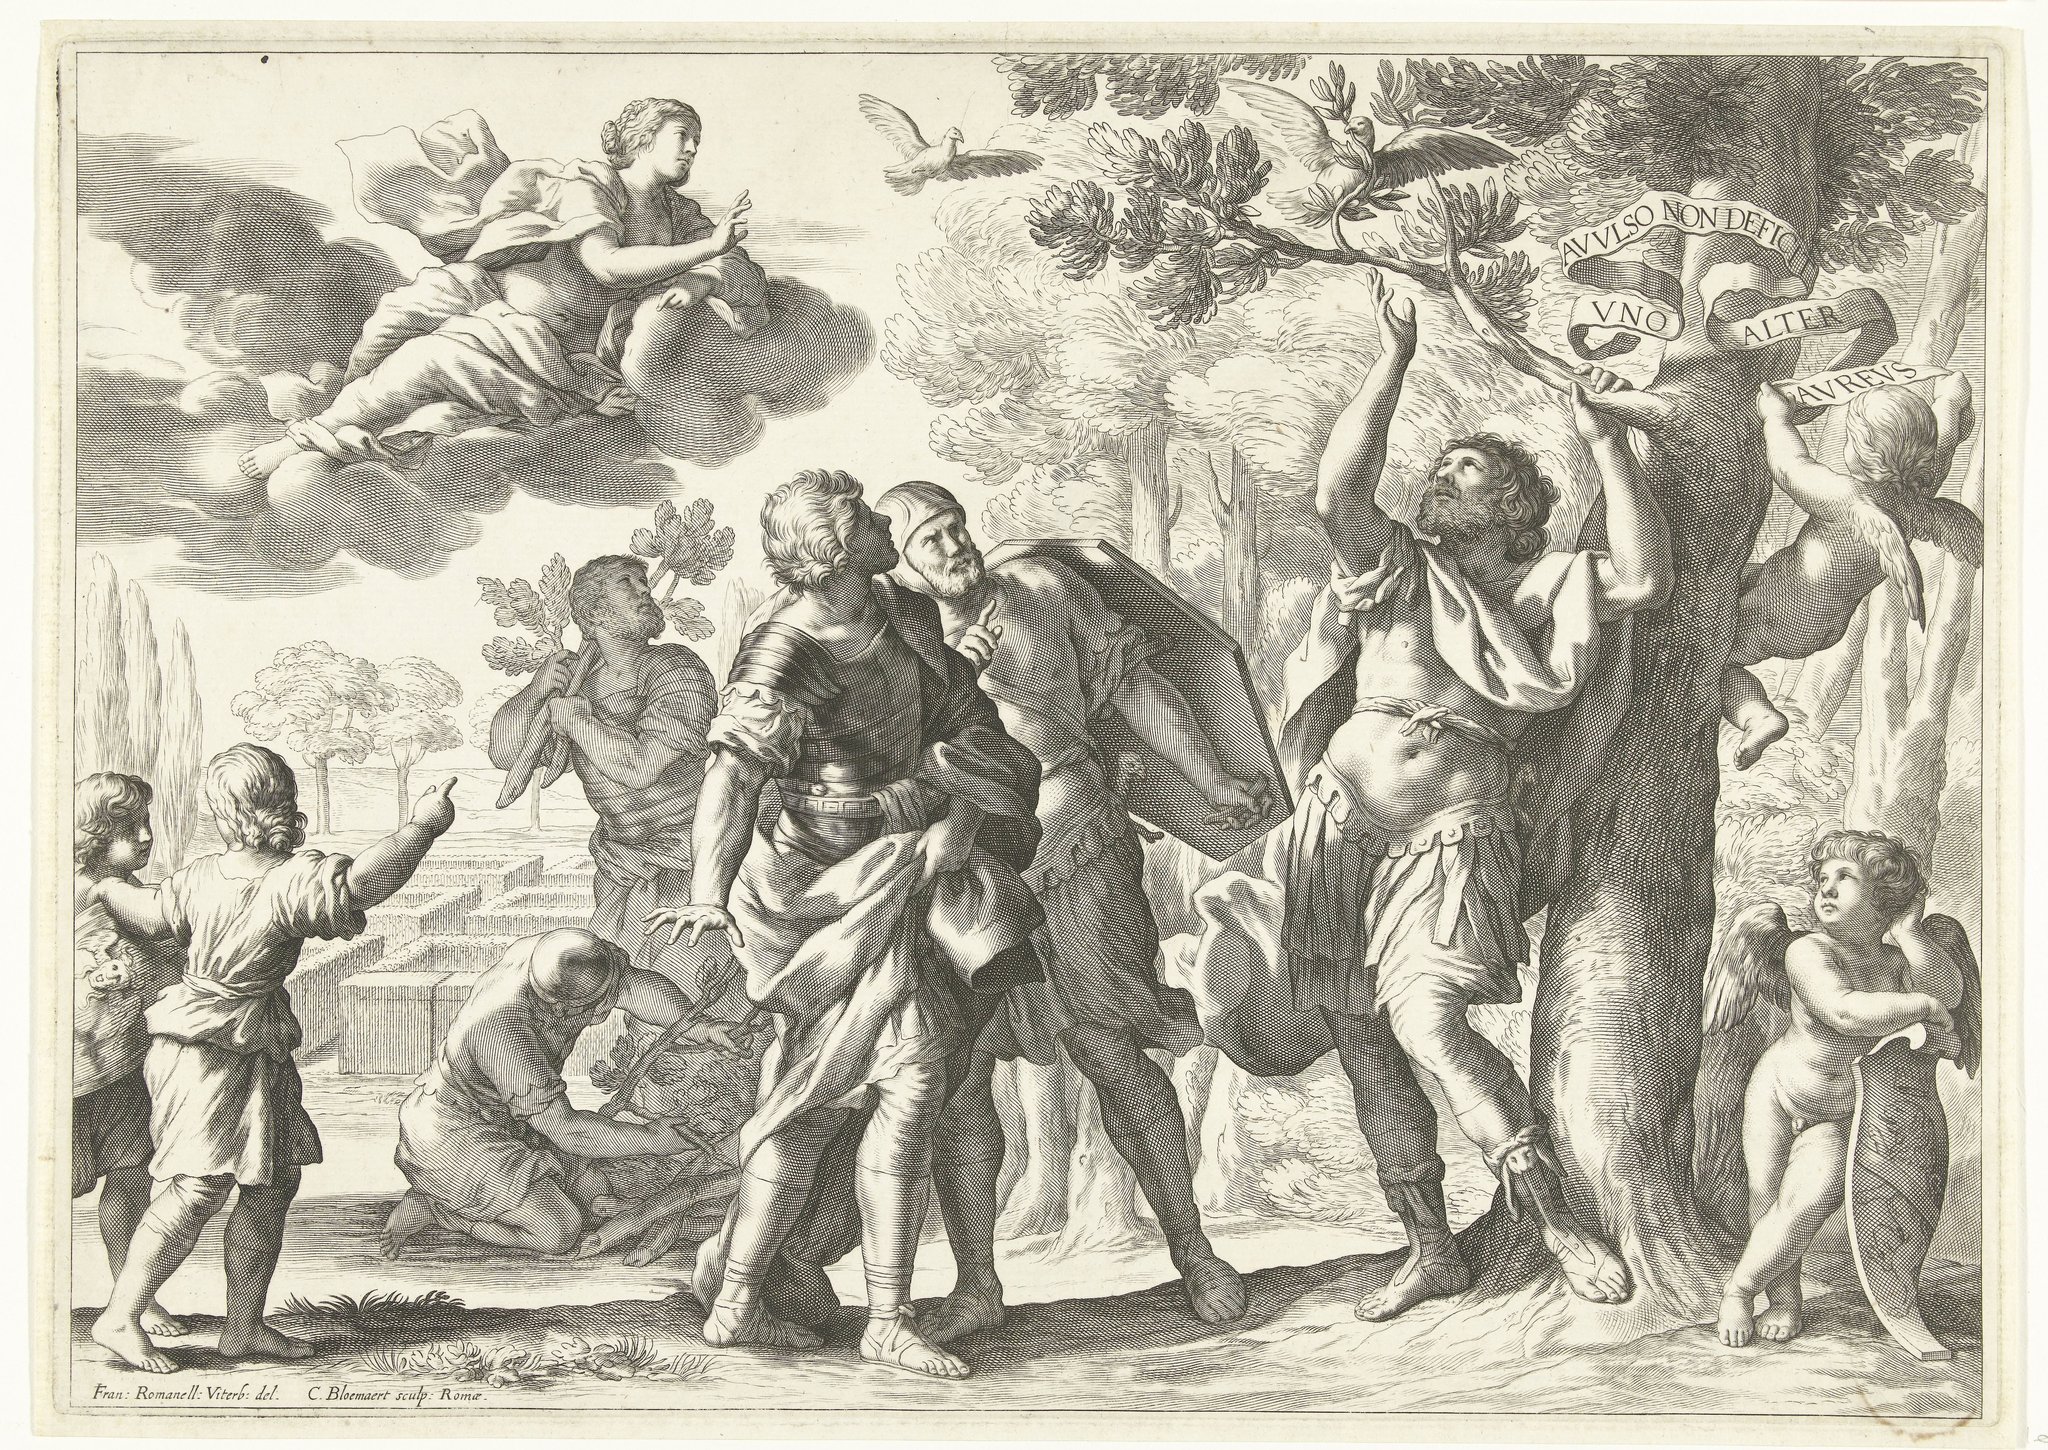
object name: print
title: Aeneas breekt de gouden tak af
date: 1633-1692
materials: paper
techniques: engraving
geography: rome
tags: aeneas plucks the 'golden bough' by the aid of two doves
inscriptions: collector's mark: Lugt 240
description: Aeneas en zijn vriend Achates zijn in het bos van Proserpina. Aeneas breekt een tak van een boom. Een duifje houdt een twijg van die tak in haar snavel. Hij heeft de tak nodig om zich op zijn weg naar de onderwereld achter die tak te kunnen verbergen.